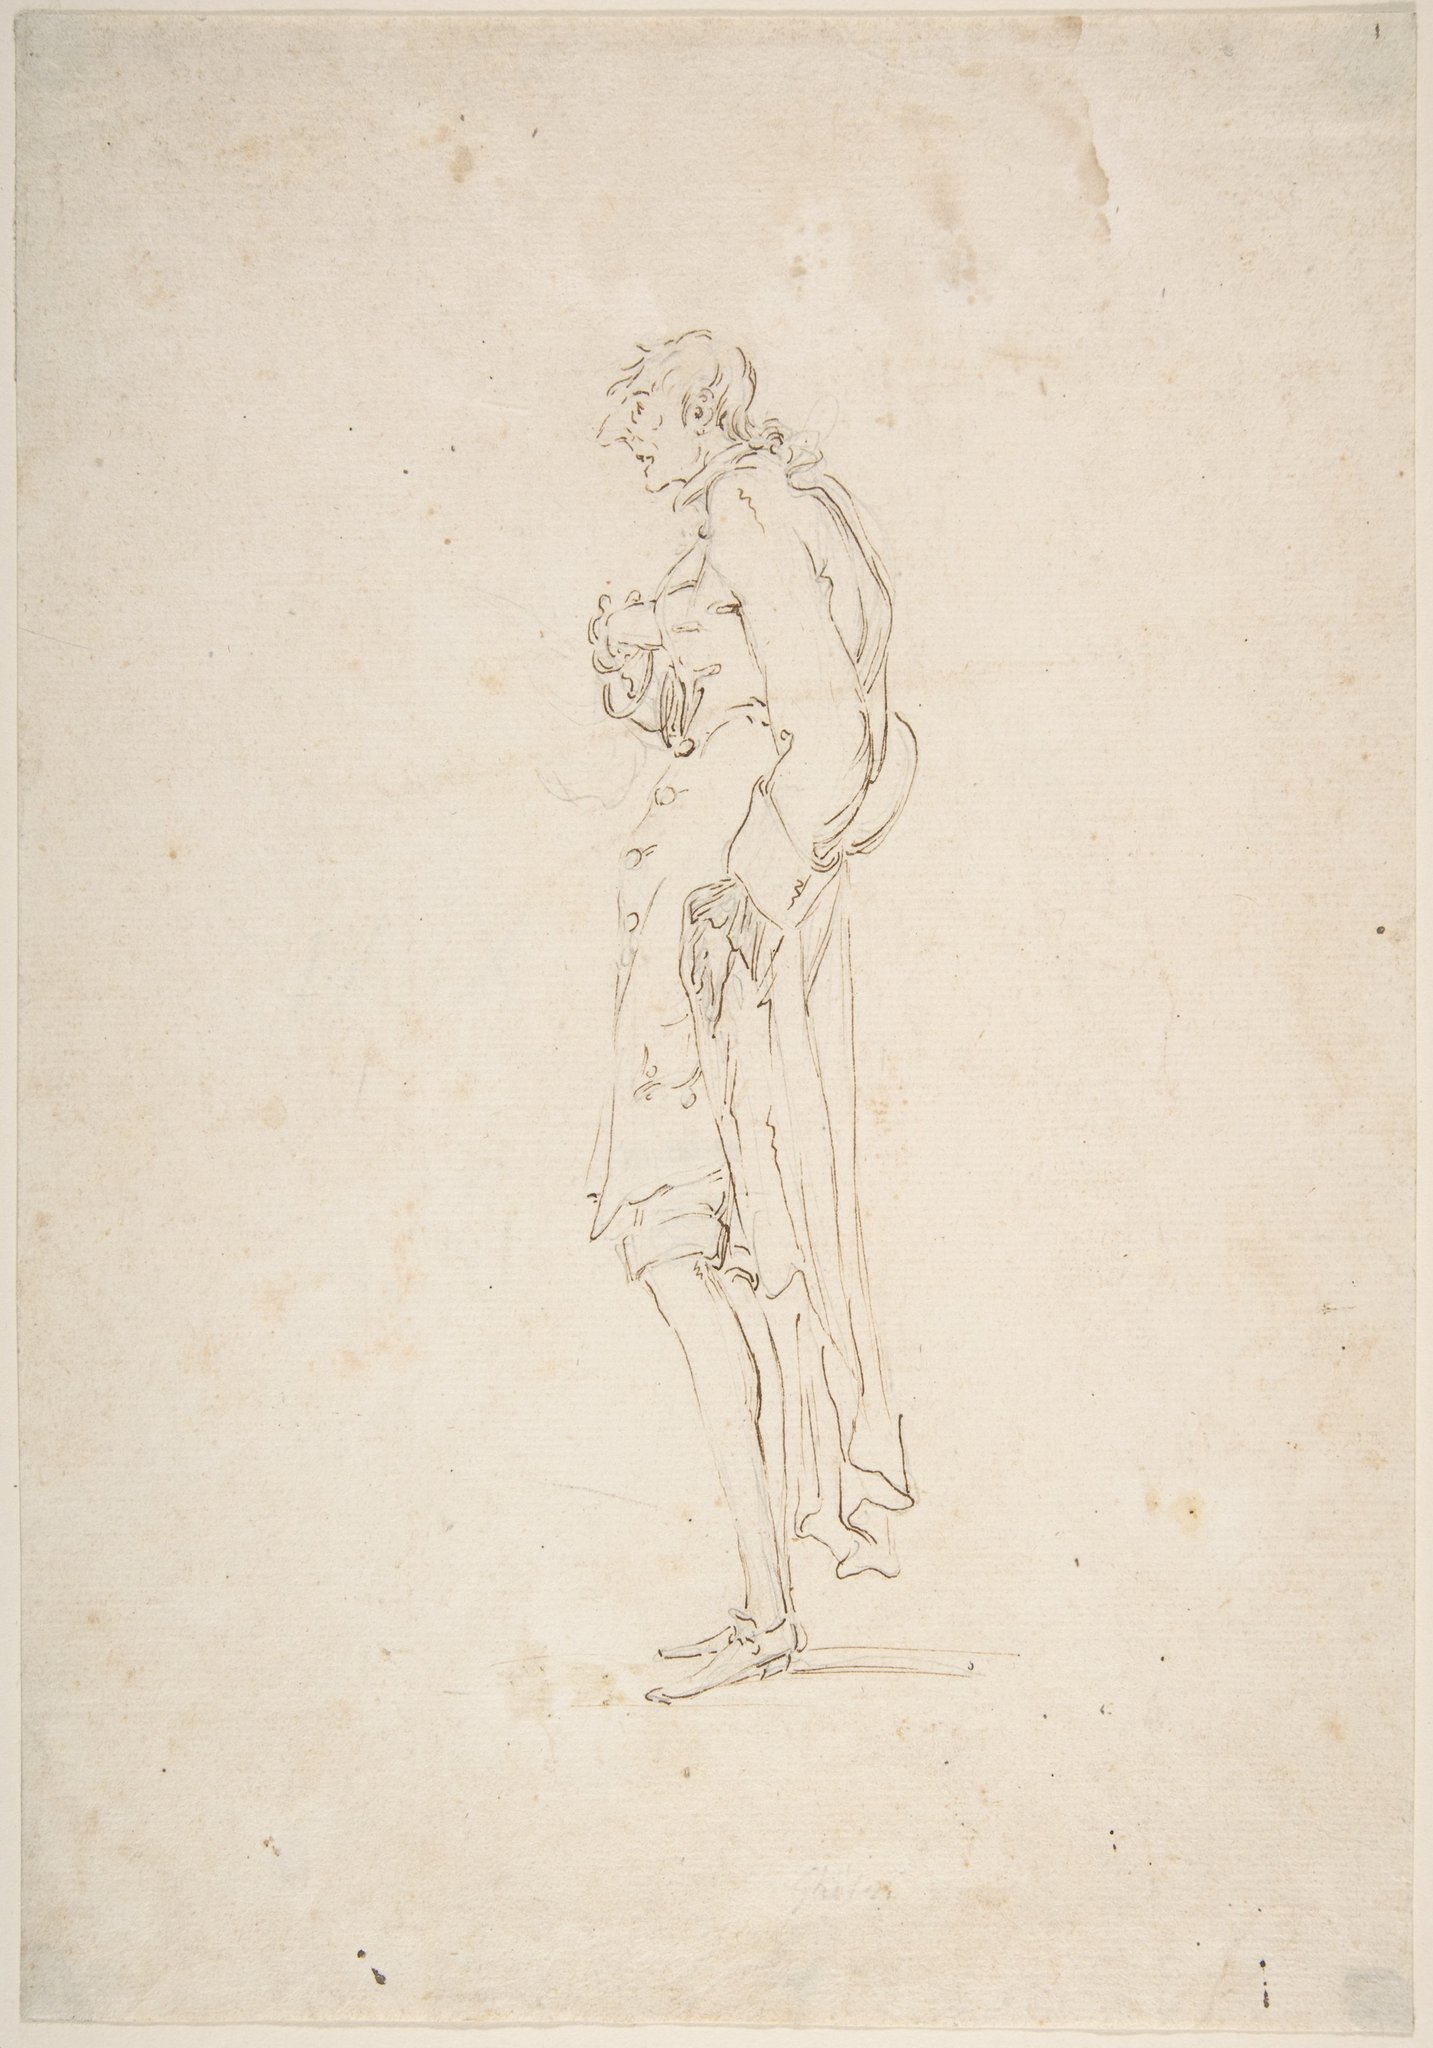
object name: drawing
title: Sketched Caricature of a Standing Man Facing Left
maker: pier leone ghezzi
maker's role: artist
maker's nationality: italian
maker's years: 1674-1755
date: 1674-1755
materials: graphite, ink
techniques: pen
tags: men